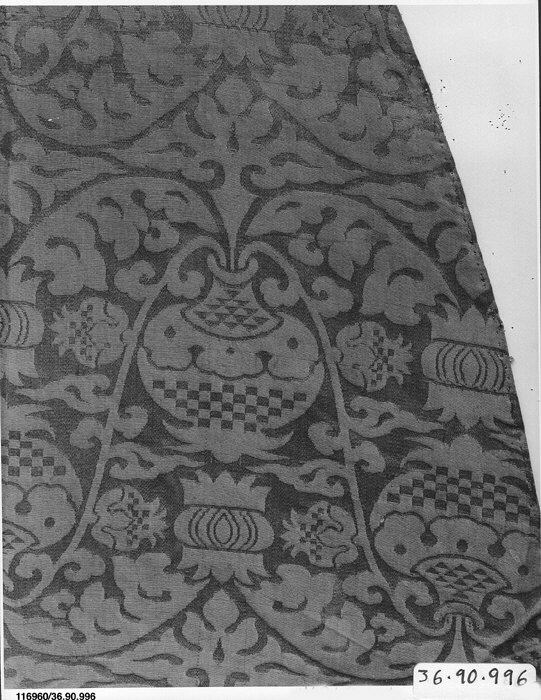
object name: piece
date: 1501-1600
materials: silk